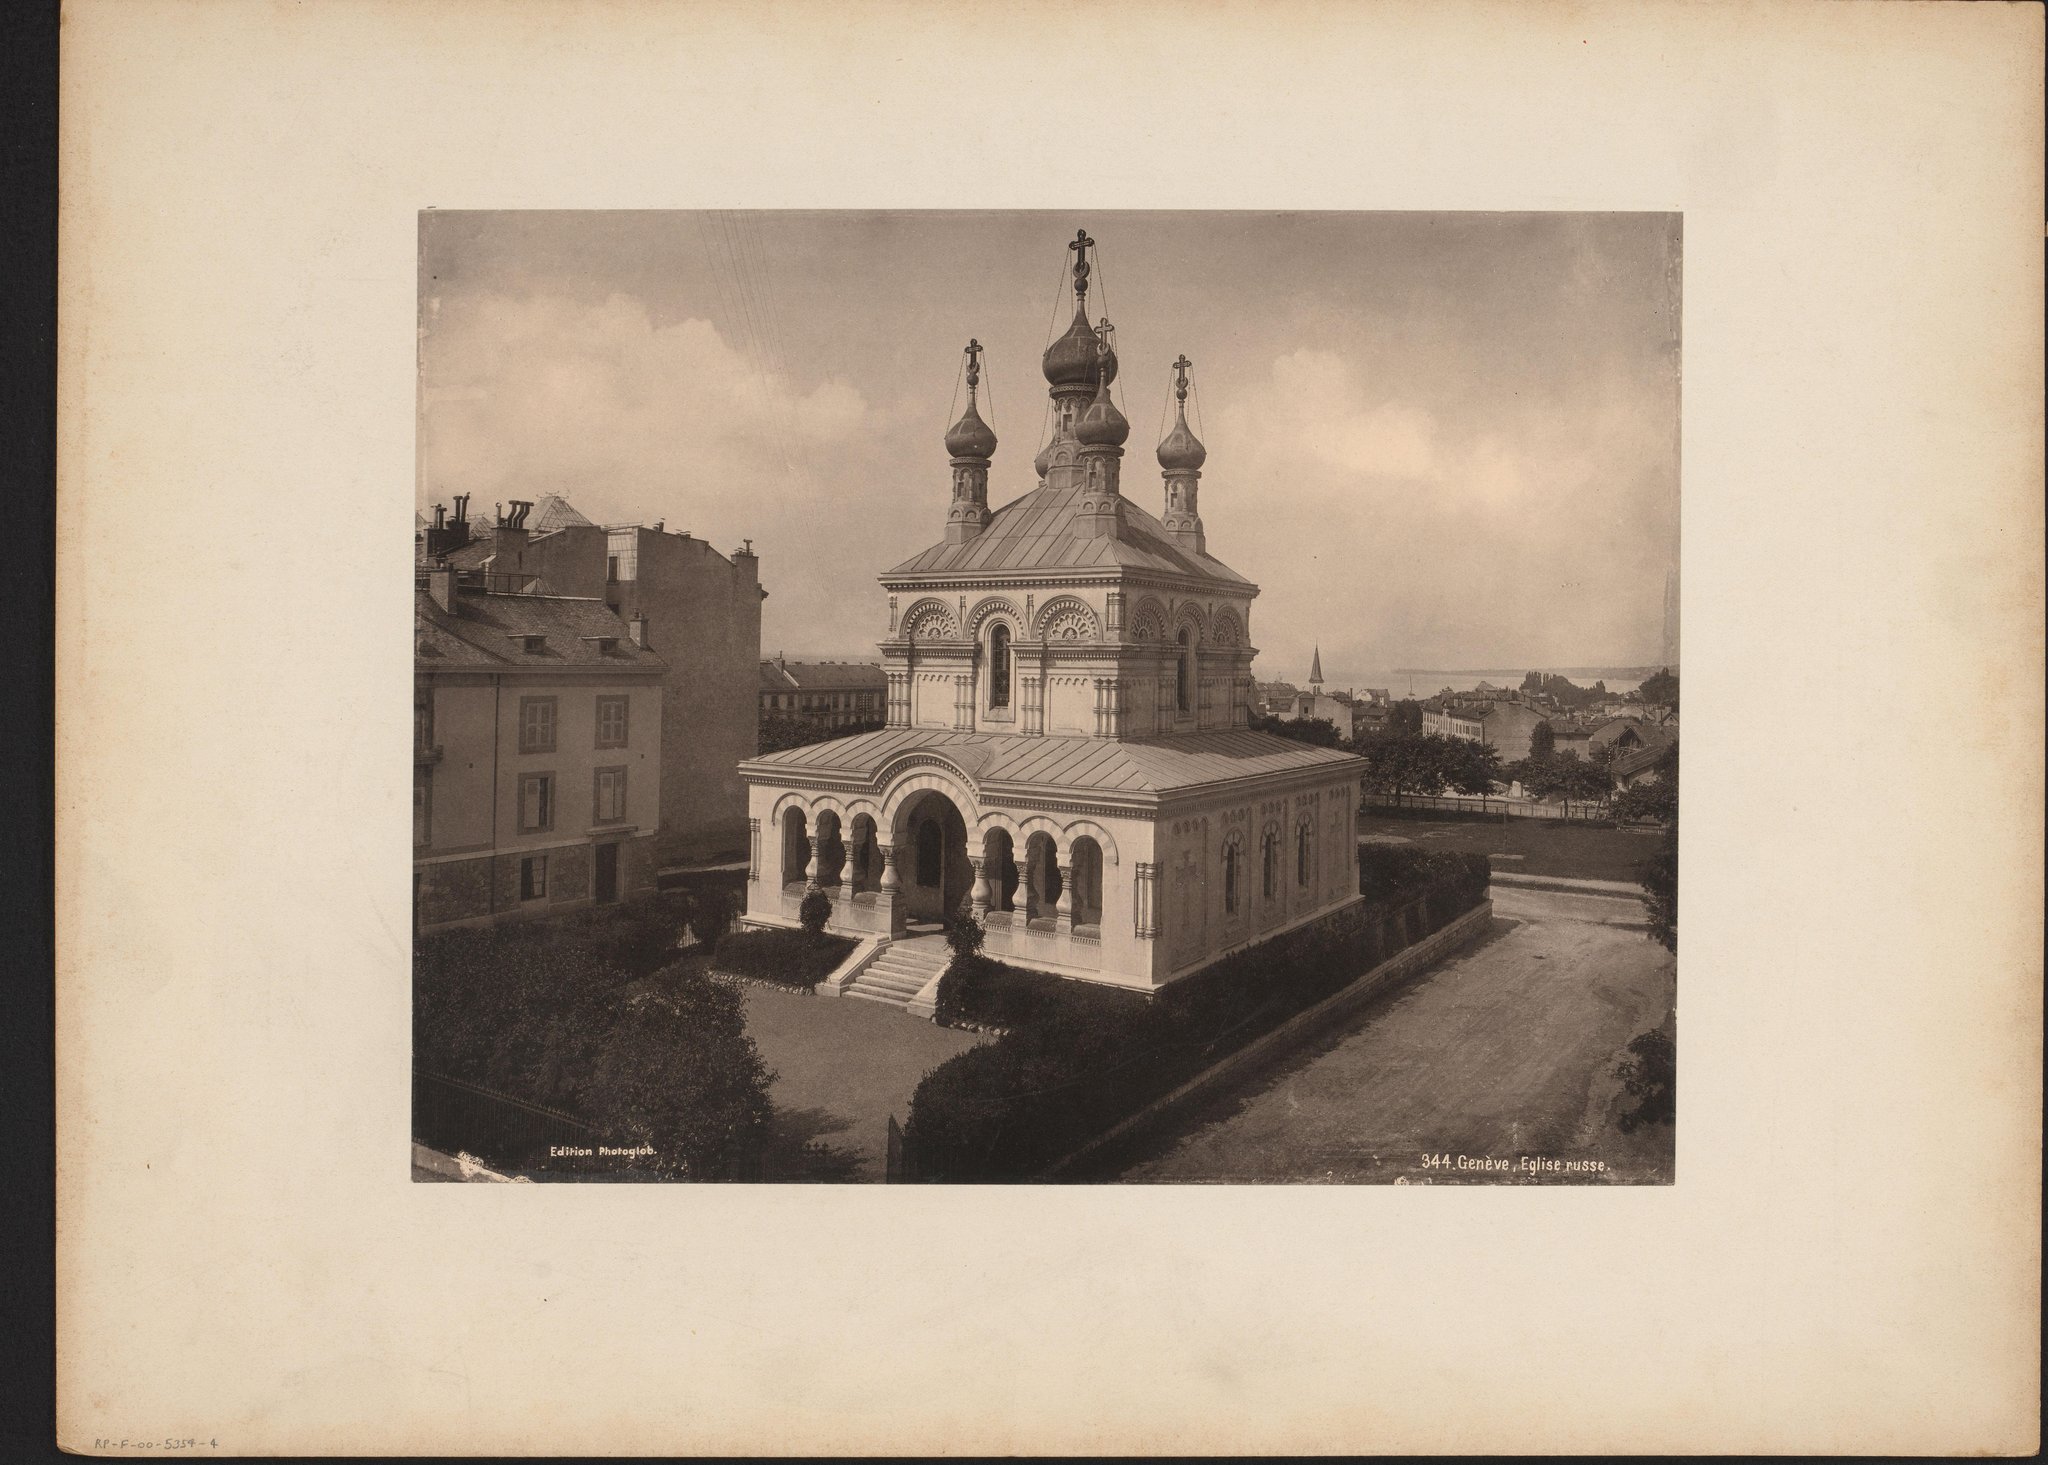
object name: photomechanical print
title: Russische kerk in Genève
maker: Anonymous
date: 1895-1910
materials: cardboard, paper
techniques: photograph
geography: geneva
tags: church (exterior)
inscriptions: inscription: ‘Edition Photoglob. 344. Genève, Eglise russe.’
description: Deze fotomechanische afdruk maakt deel uit van een omslag.